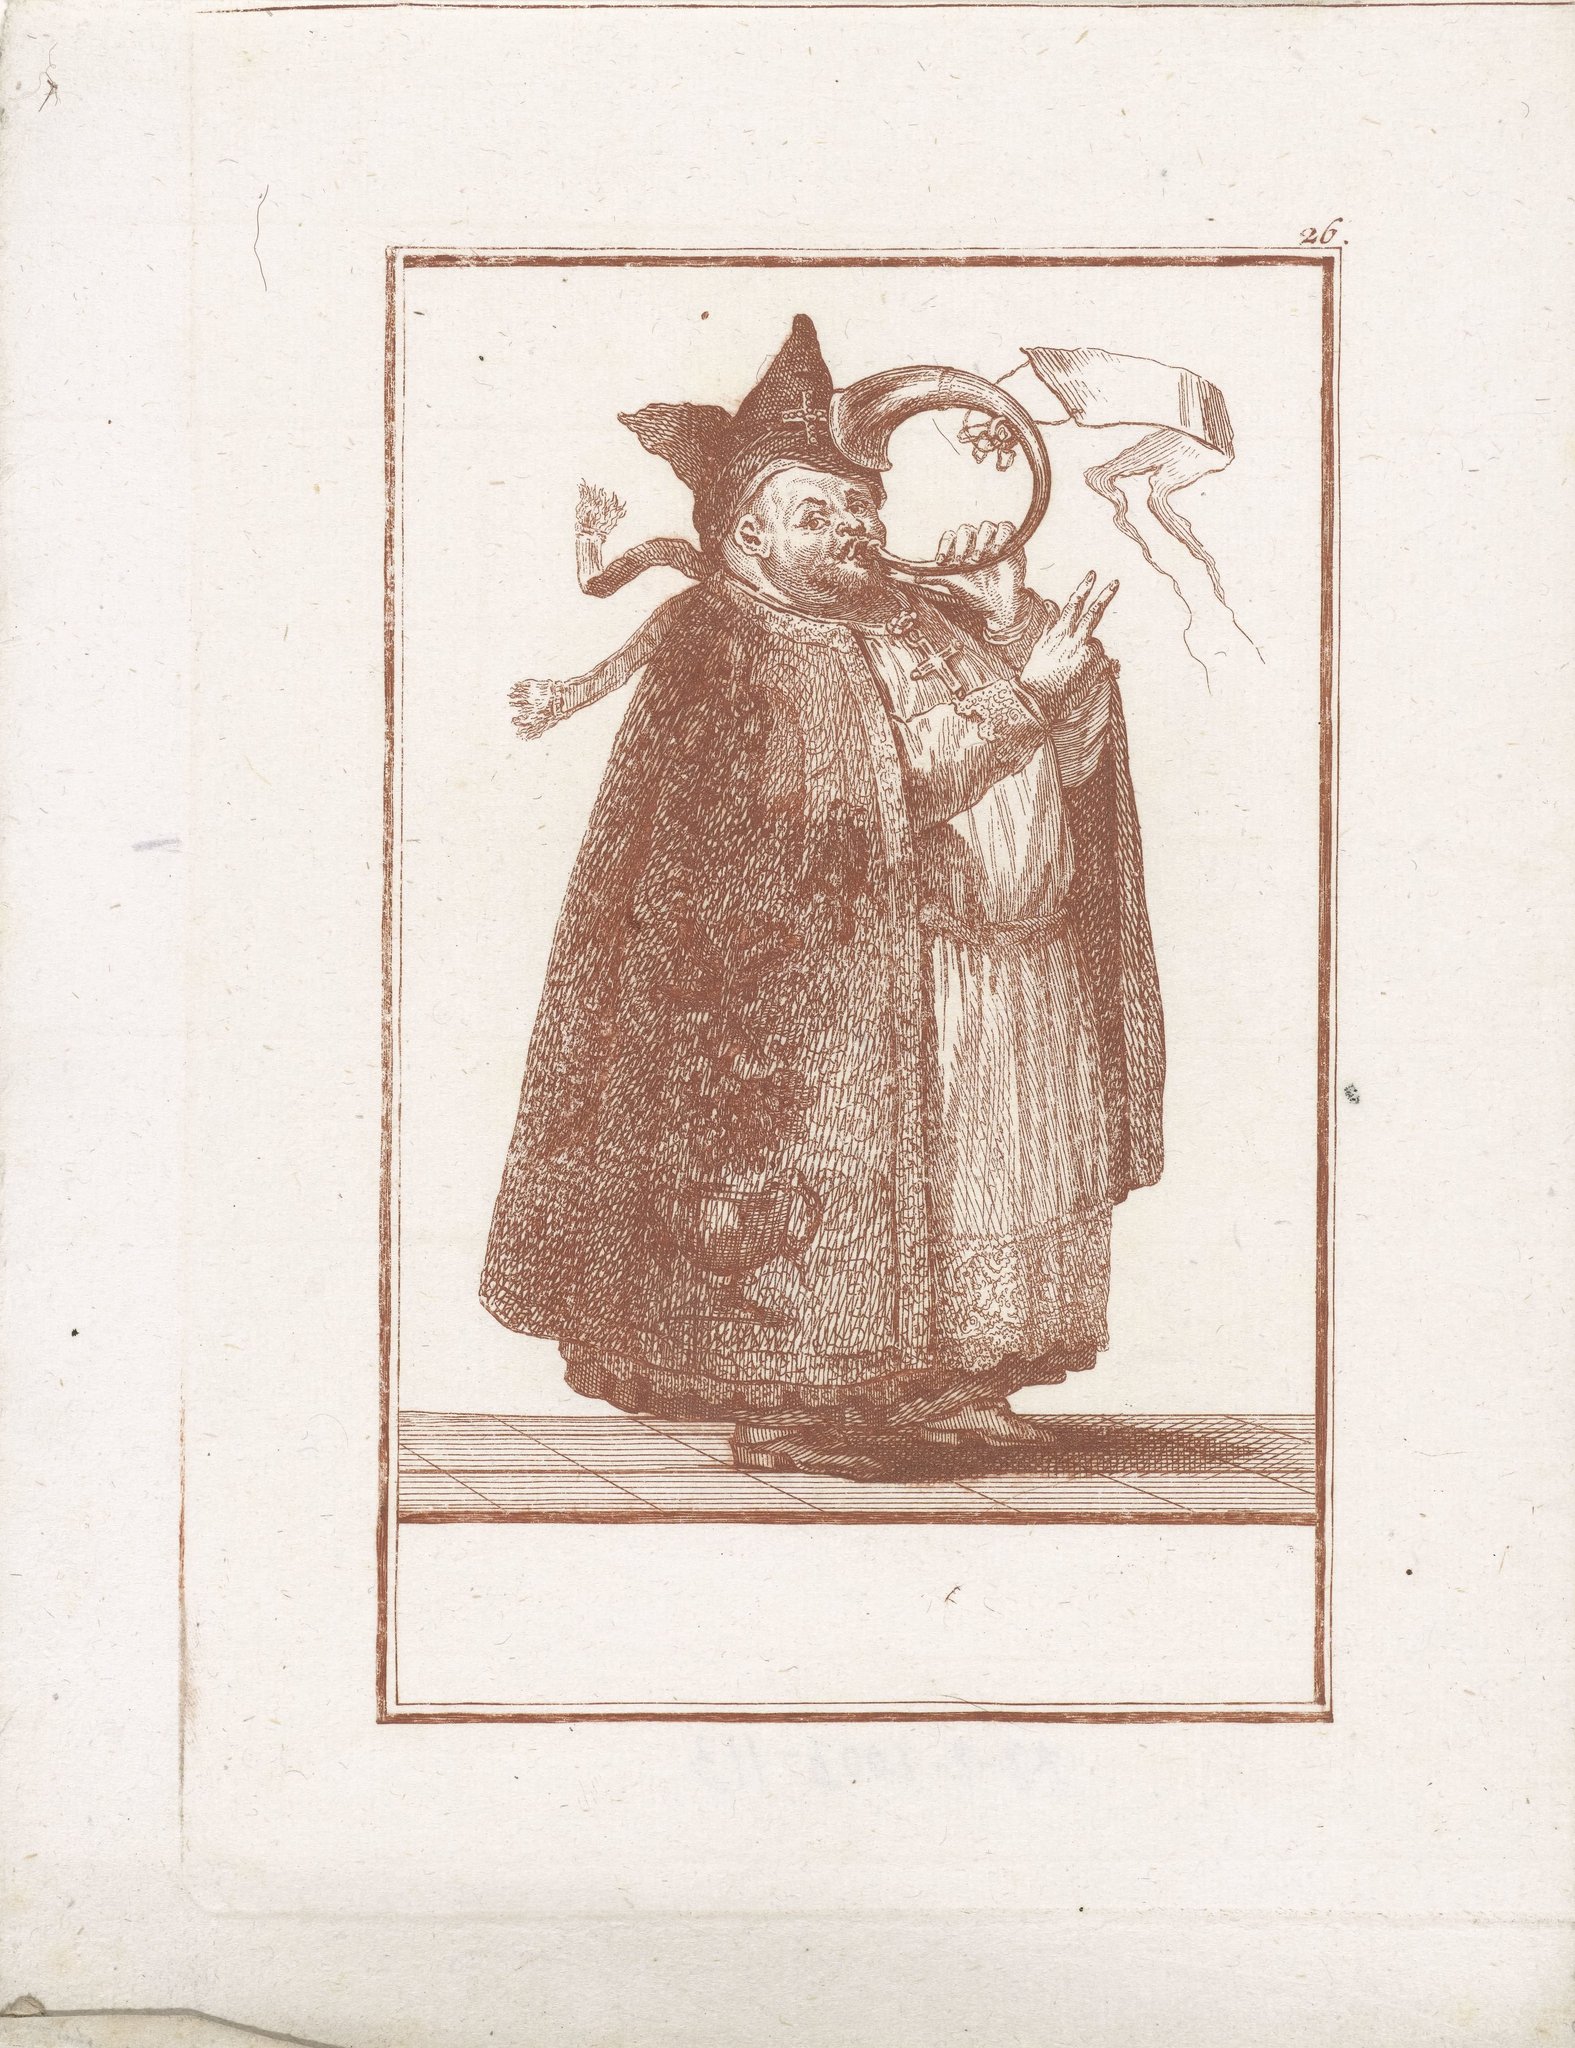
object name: cartoon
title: L'Abregé du Faux Clerge Romain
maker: jacob gole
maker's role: print maker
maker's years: 1660-1724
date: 1724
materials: paper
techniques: etching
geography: amsterdam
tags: fat (human type), hunting horn, monk(s), friar(s), blowing the hunting horn, (aspects of) christian religion or the church (as institution) ridiculed, criticized, or caricaturized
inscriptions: collector's mark: Lugt 2228, collector's mark: Lugt 2760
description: Dikke monnik met puntmuts. Hij blaast een jachthoorn, waaraan een wimpel is vastgemaakt. De prent is deel van een 50-delige serie met als onderwerp de misbruiken van de katholieke geestelijkheid.